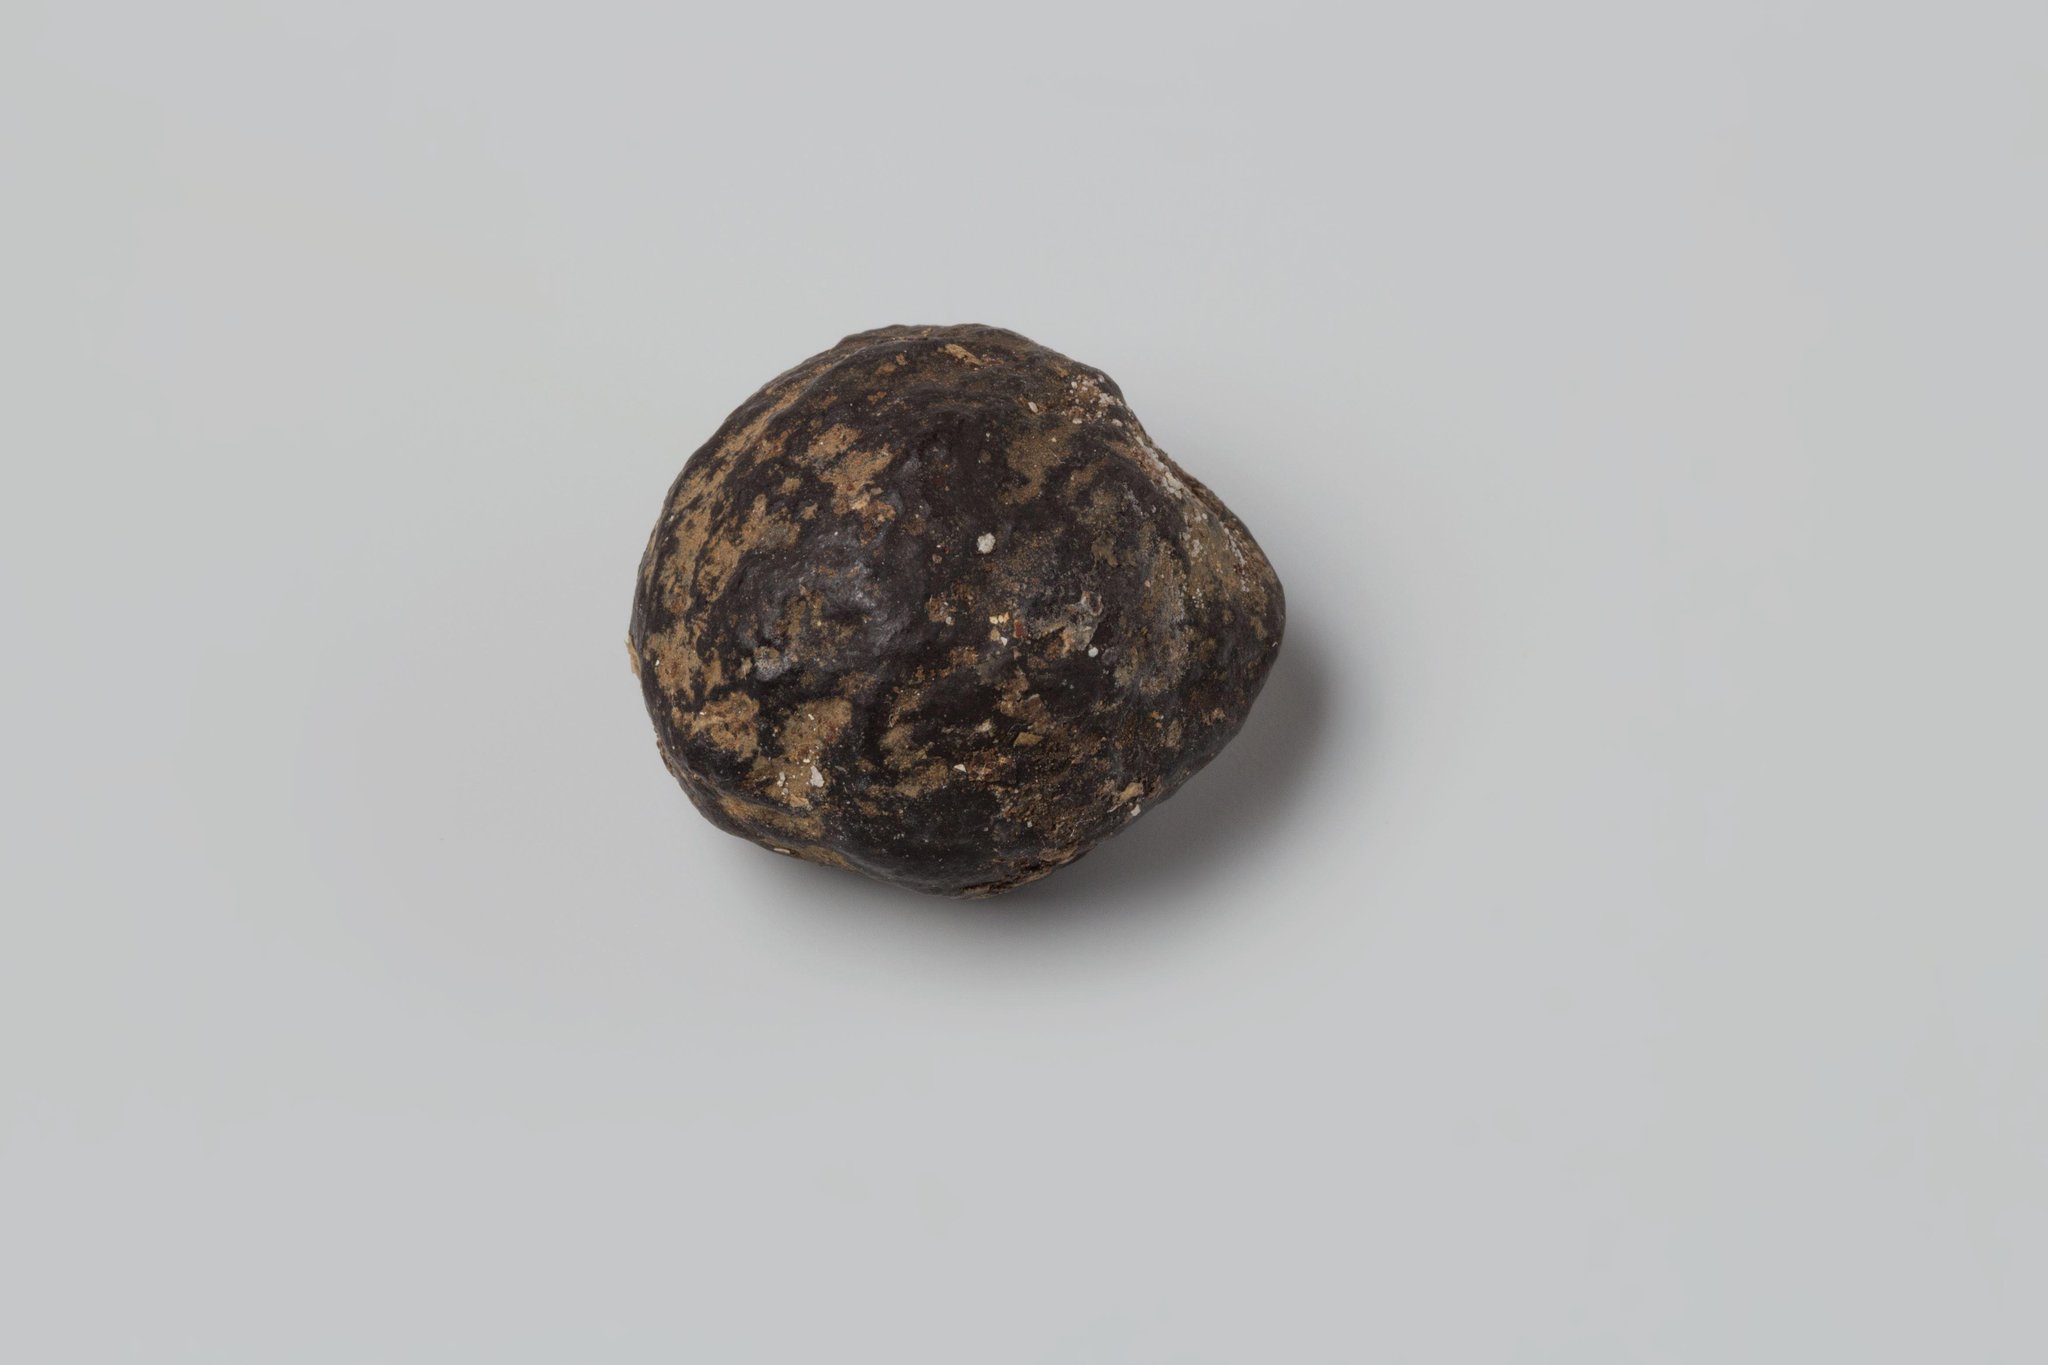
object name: nut plant material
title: Kemirinoot uit V.O.C.-schip de 'Witte Leeuw'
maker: Anonymous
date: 1613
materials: nut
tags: verenigde oostindische compagnie, sint-helena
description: Kemirinoot uit V.O.C.-schip de 'Witte Leeuw'.